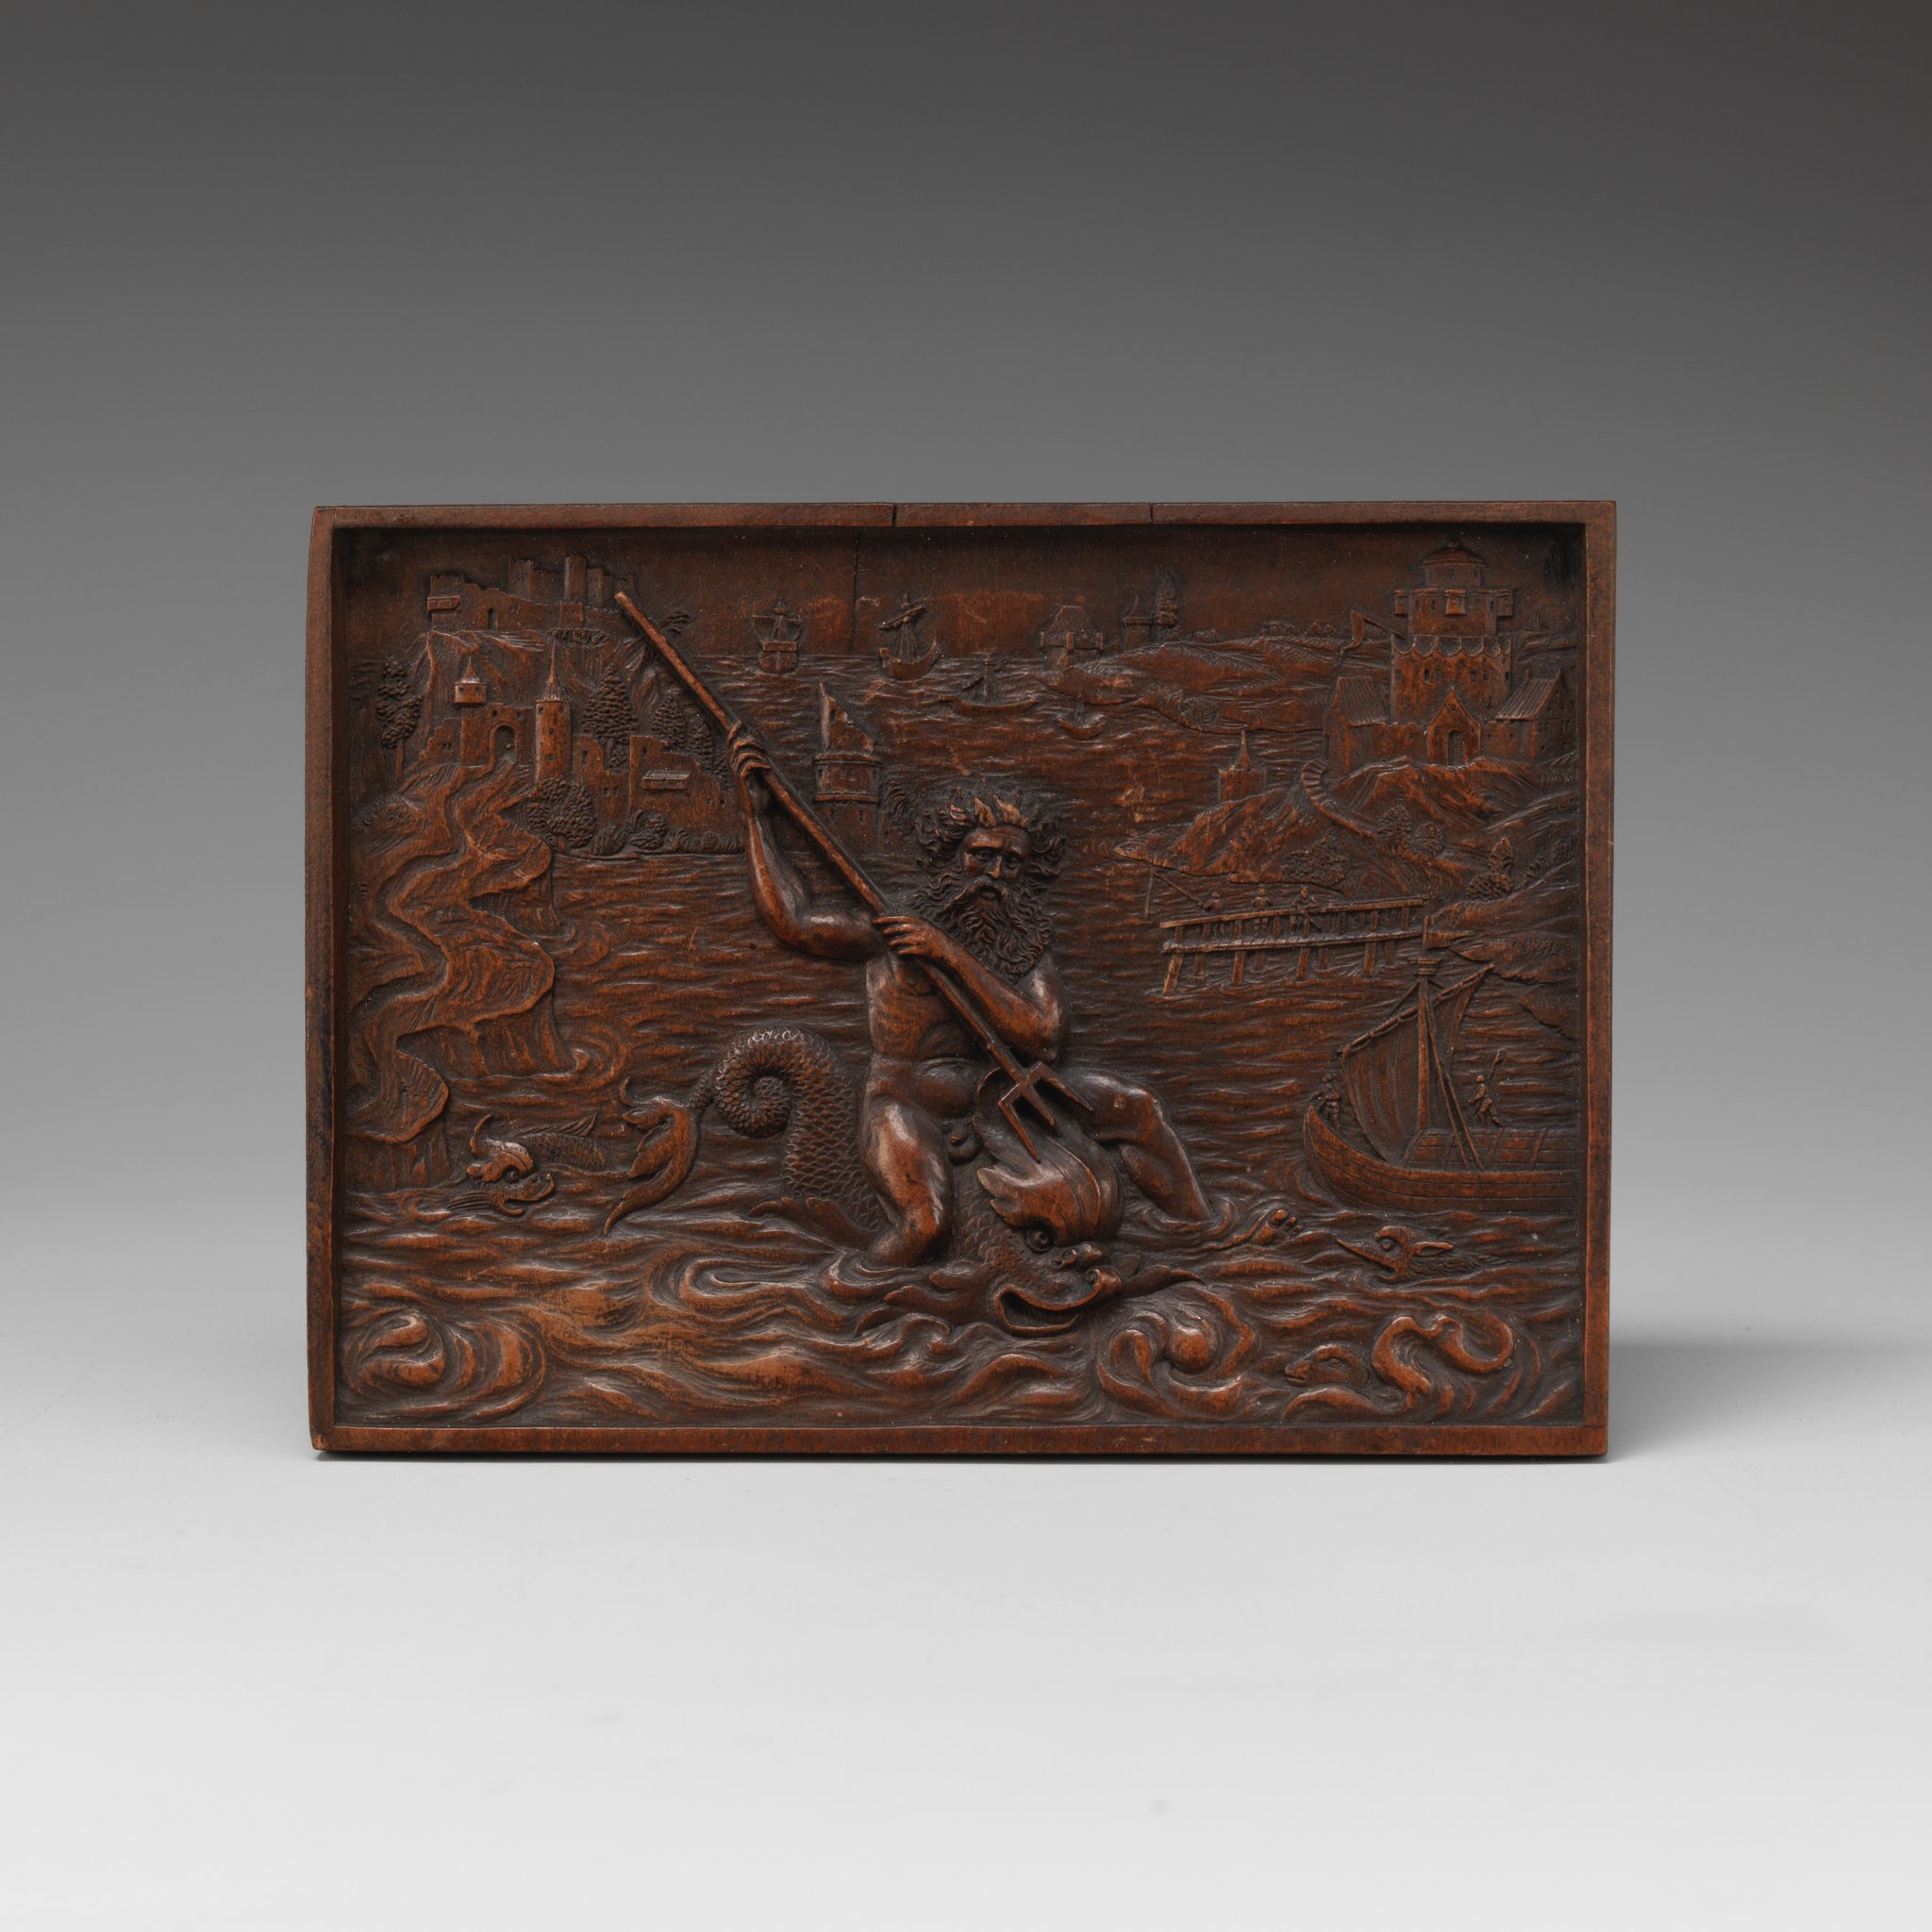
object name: relief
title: Neptune Riding a Dolphin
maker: peter flötner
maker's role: artist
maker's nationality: german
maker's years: 1485-1546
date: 1530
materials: wood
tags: neptune,dolphins,boats